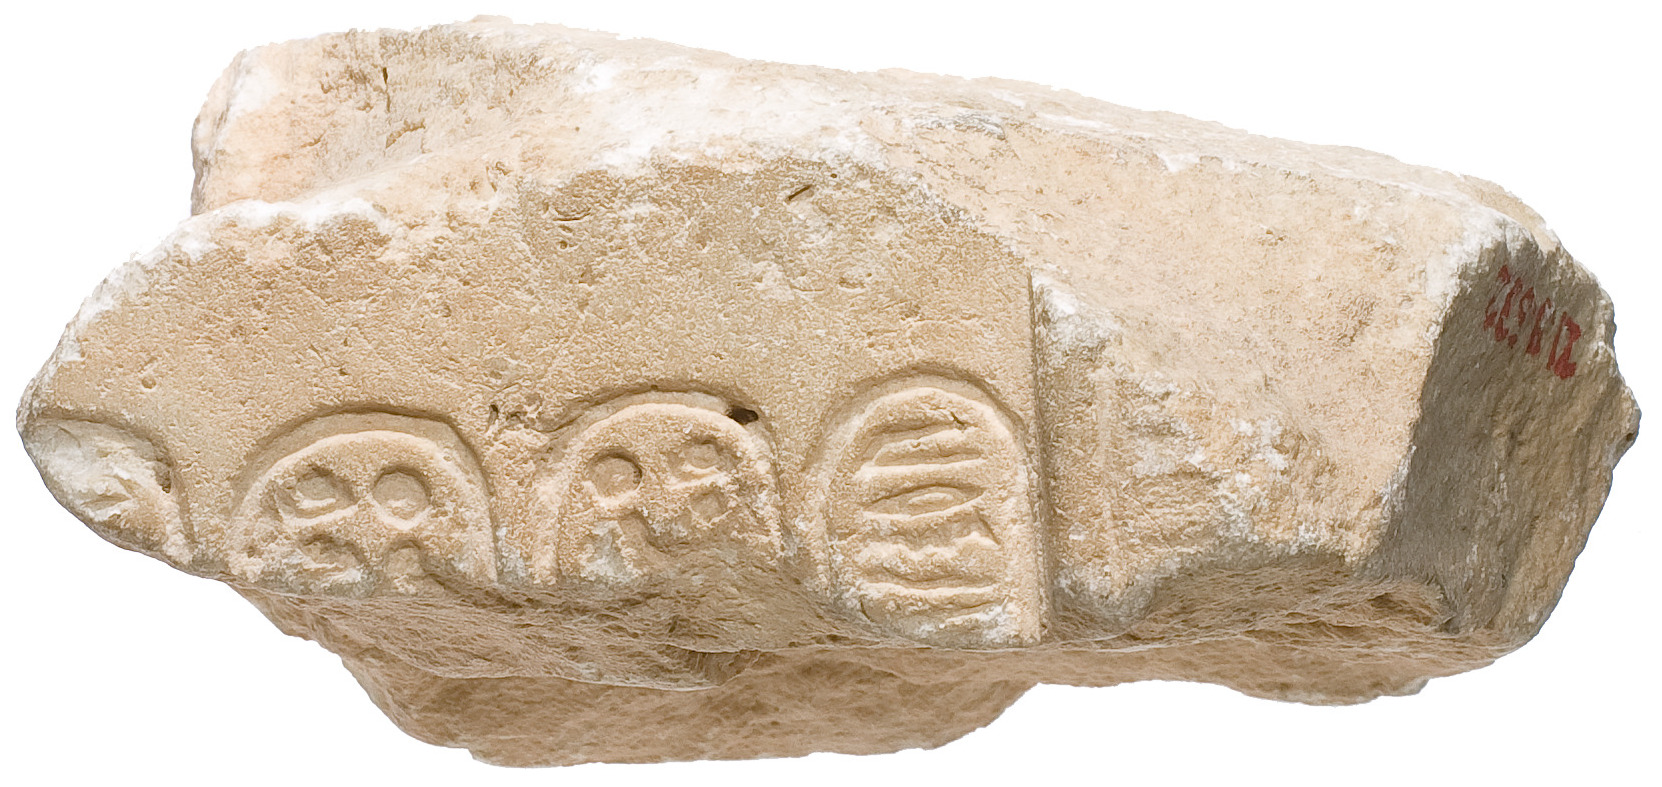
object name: inscribed fragment, aten cartouche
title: Fragment with Aten cartouches and raised border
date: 1353-1336 BCE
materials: limestone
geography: egypt